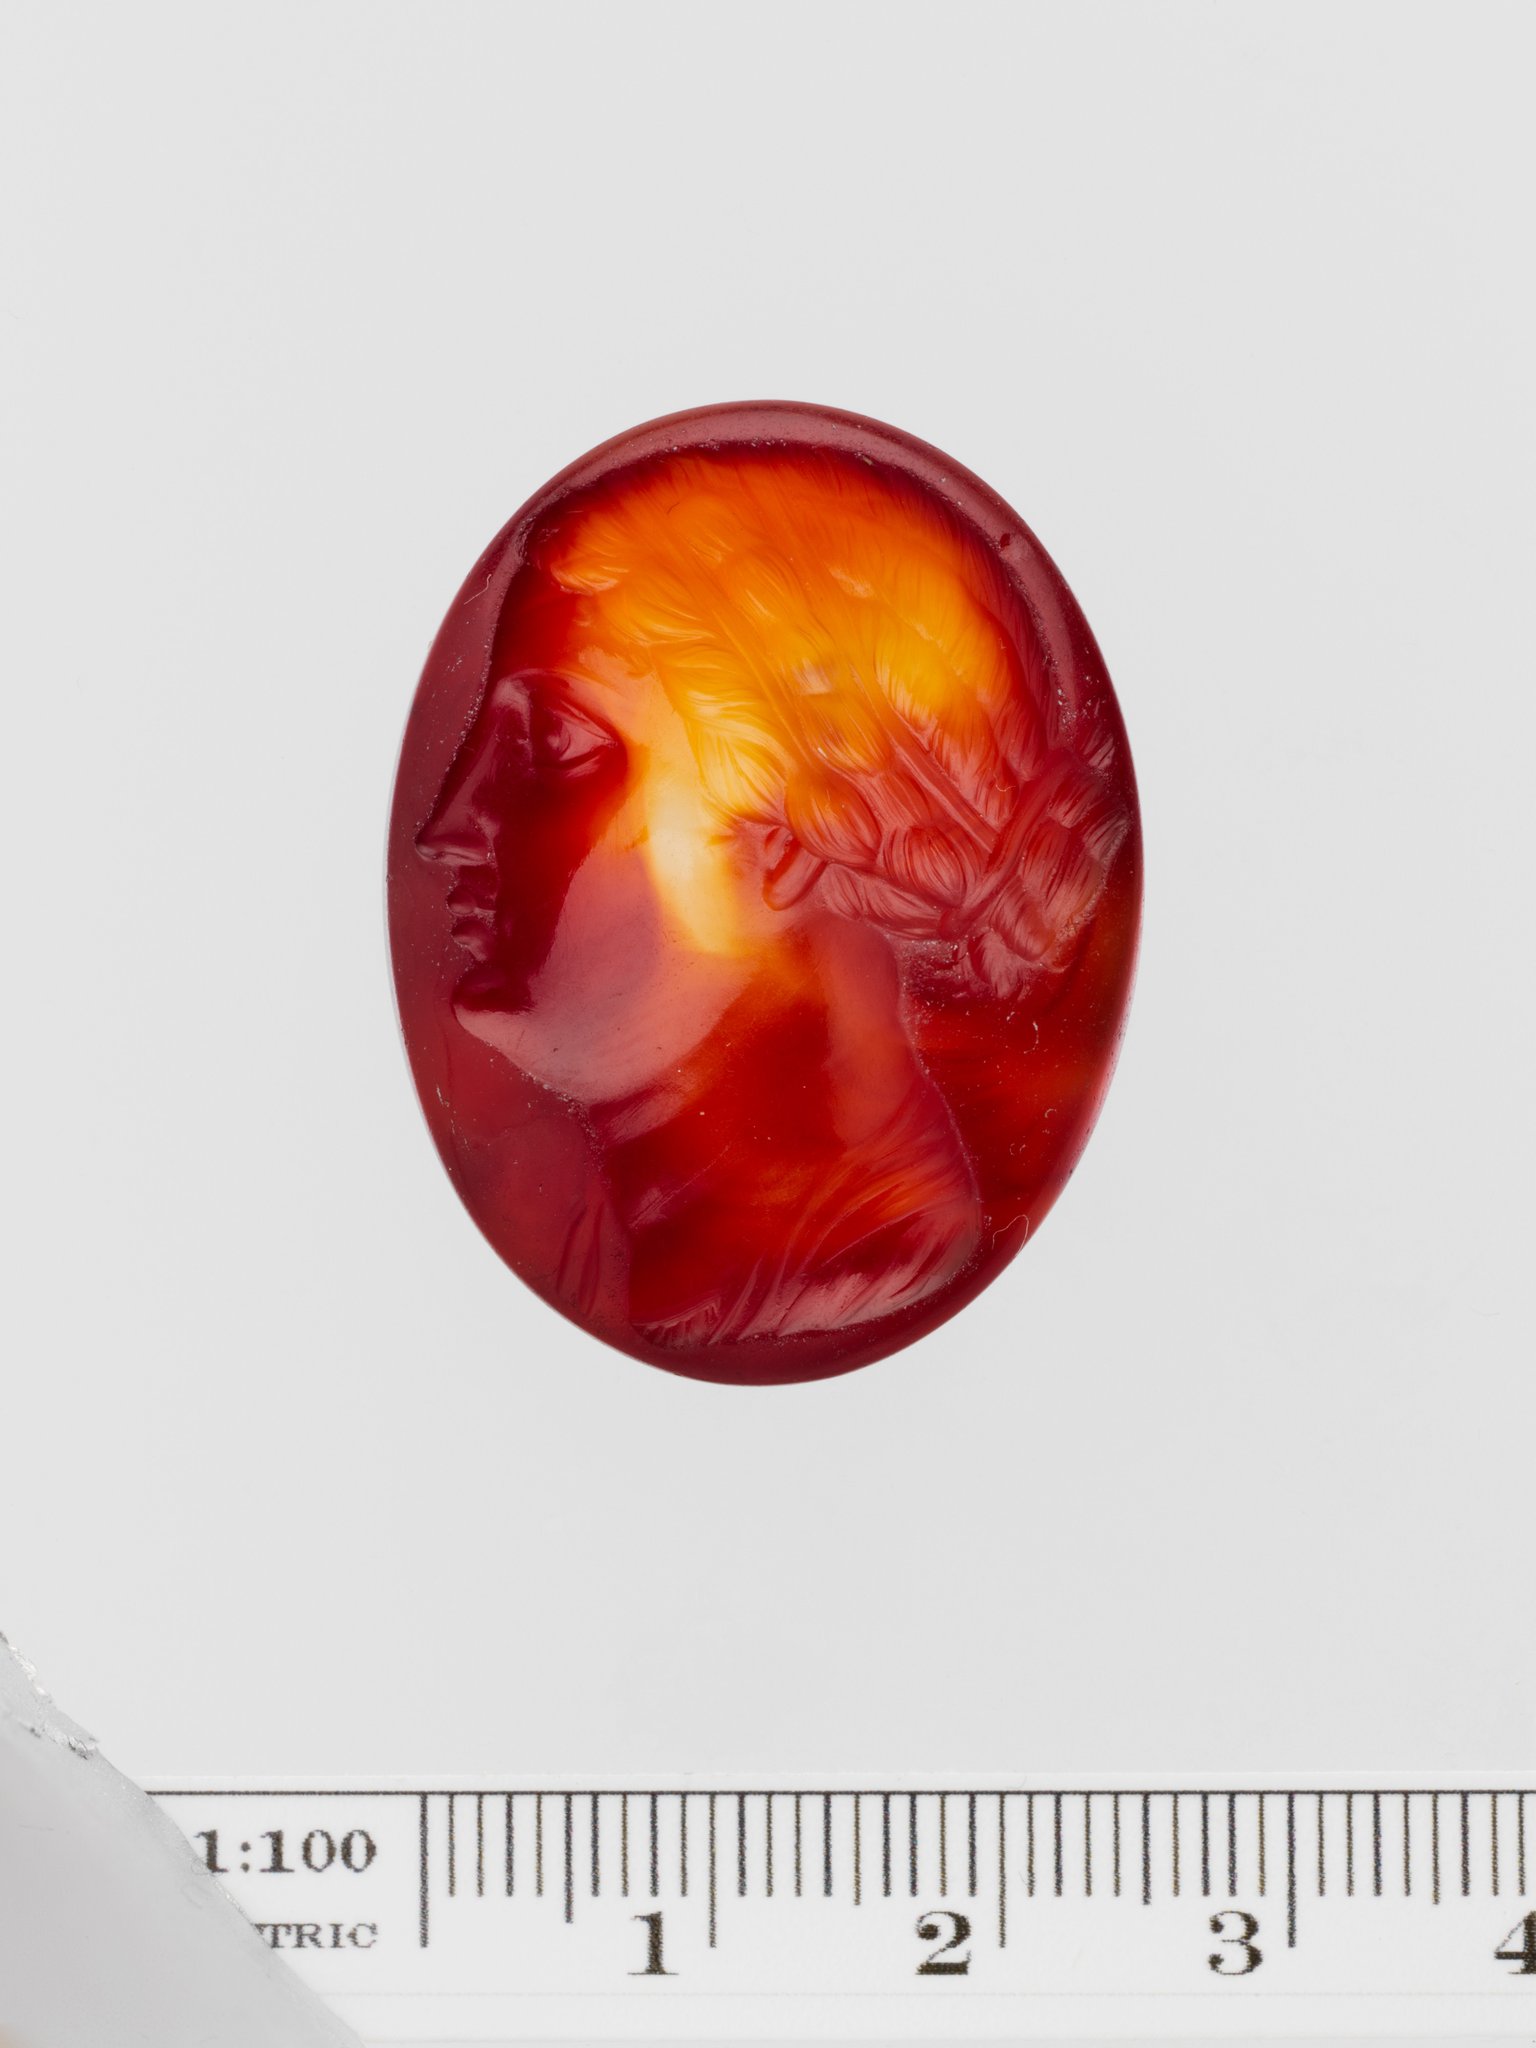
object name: intaglio of woman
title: Carnelian oval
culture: greek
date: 300-201 BCE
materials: gemstone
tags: profiles,women